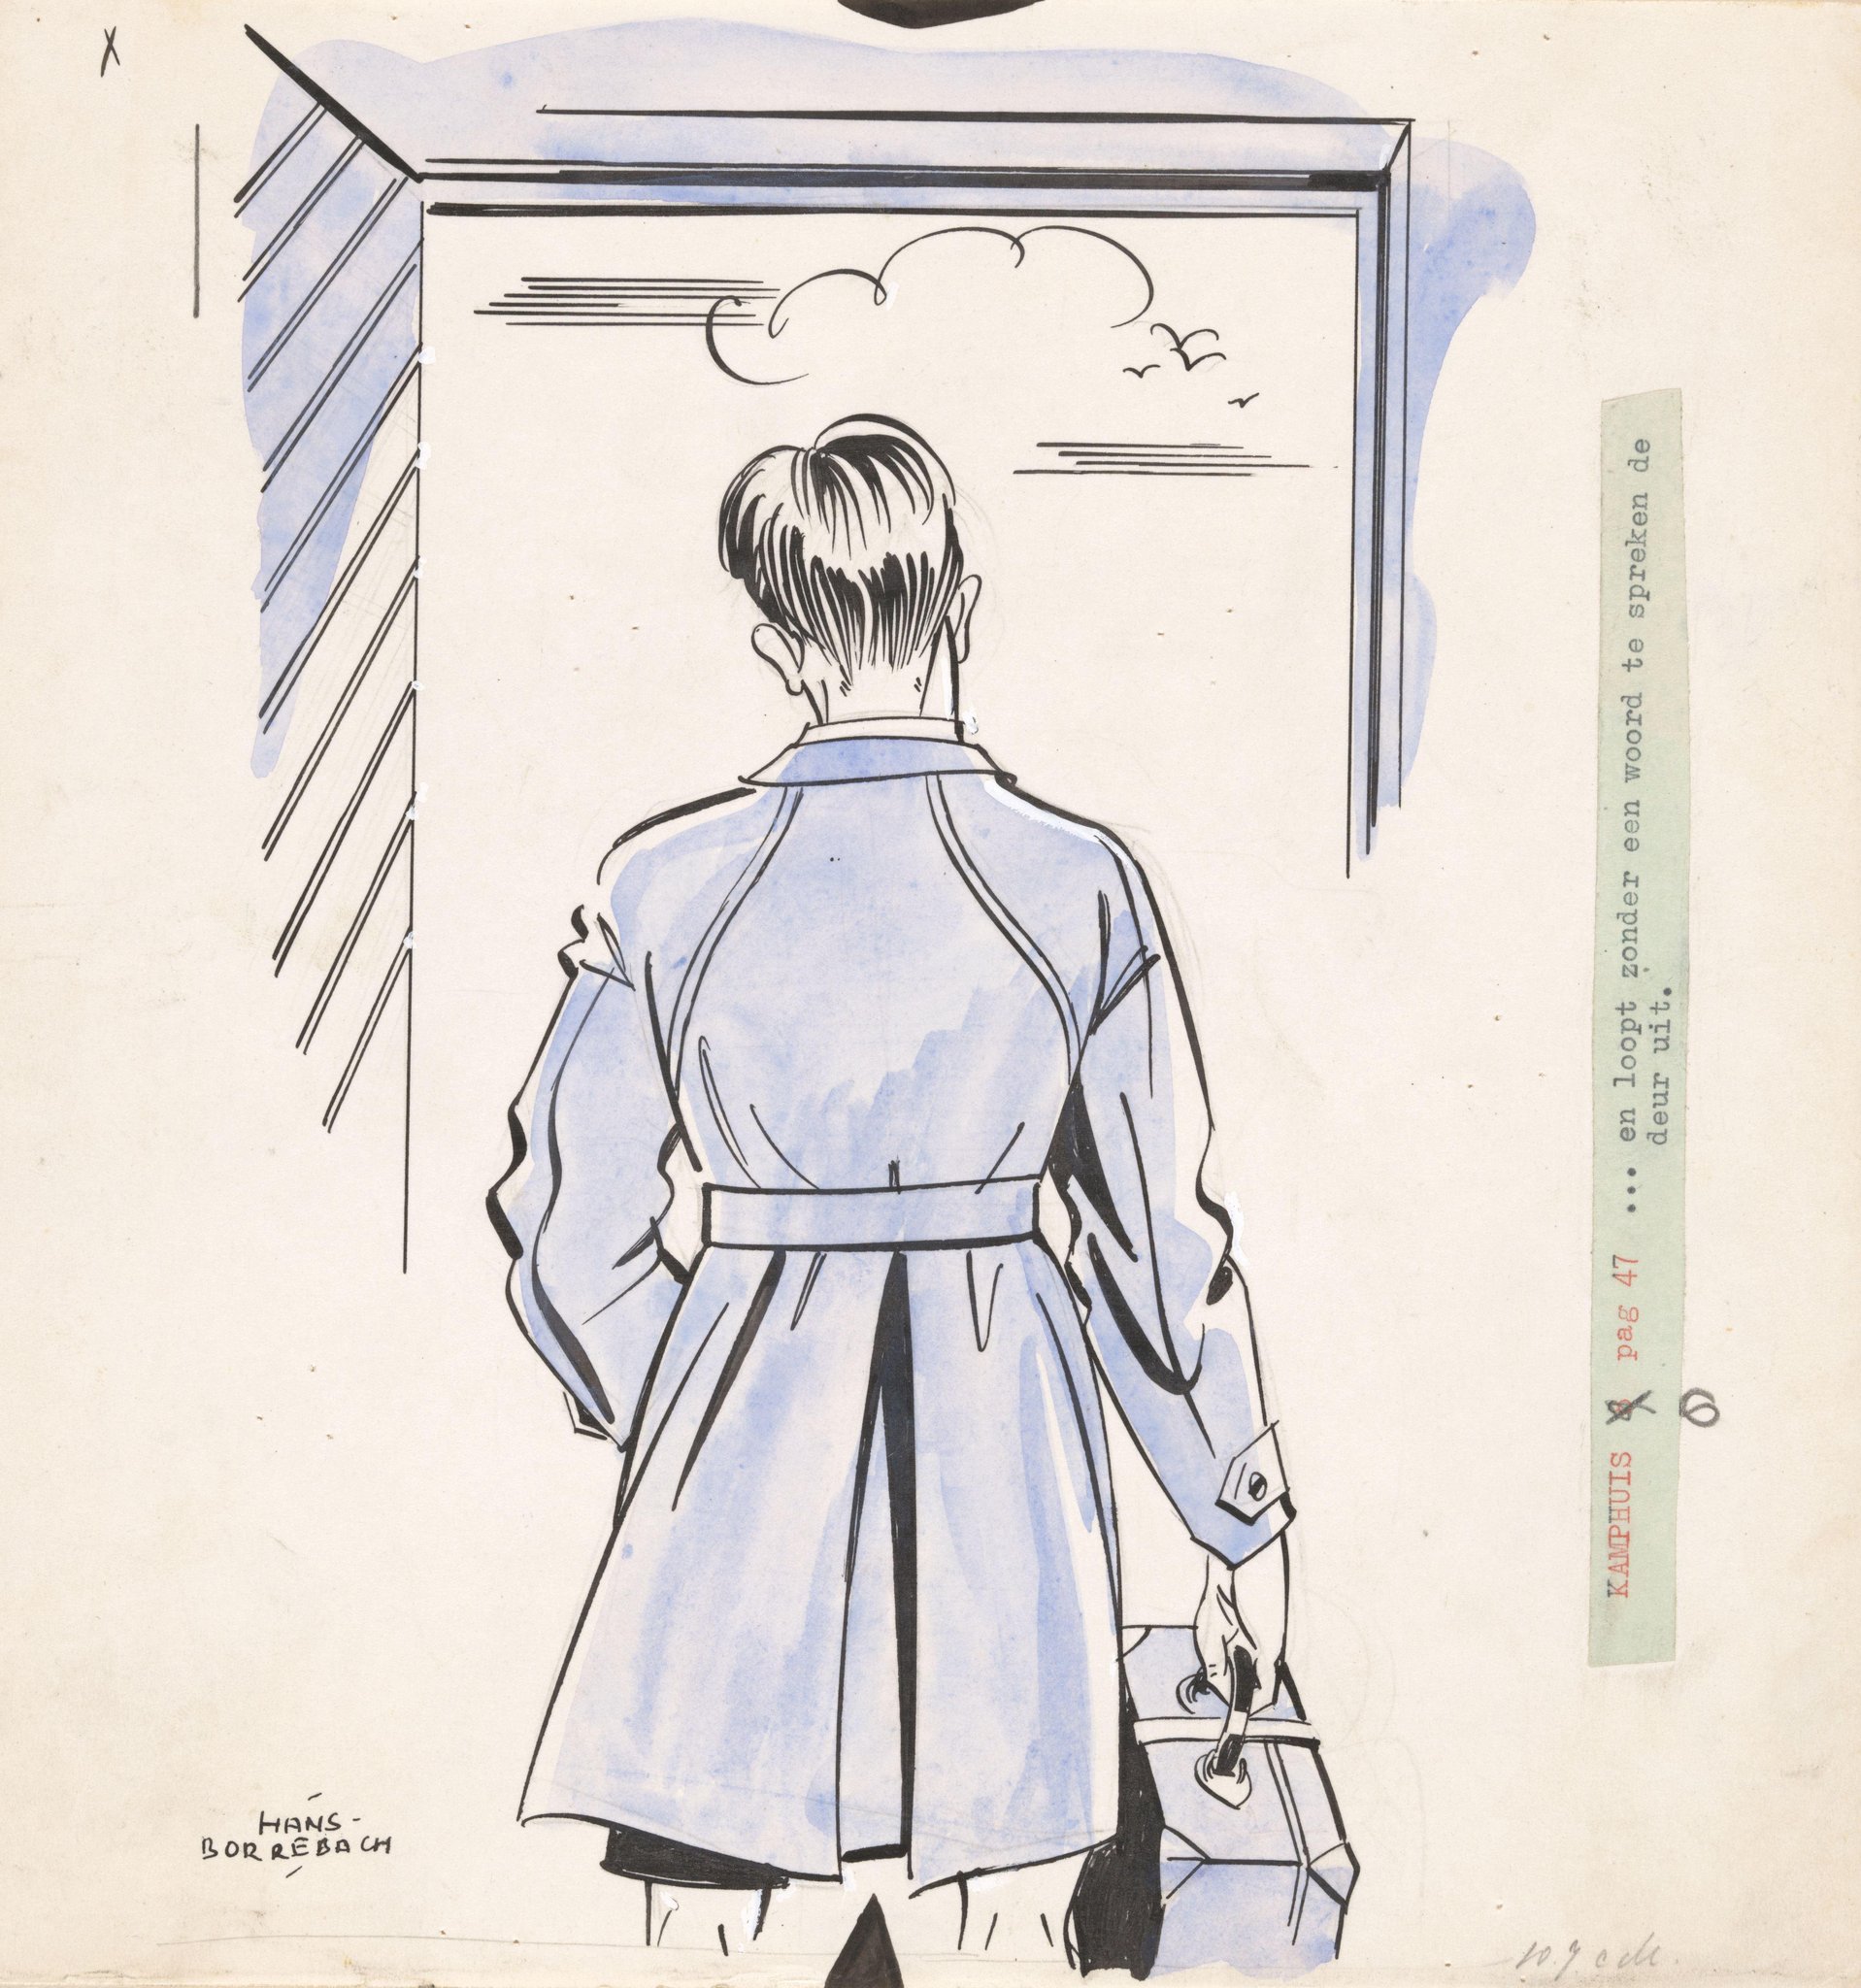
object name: drawing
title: Jonge man met koffer in een deuropening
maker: hans borrebach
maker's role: draughtsman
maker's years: 1903-1991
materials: paint, ink, paper, pencil, watercolor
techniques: brush, pen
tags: standing figure, open door, trunk, suit-case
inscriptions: collector's mark: Lugt 2228a, number: ‘X’, signature: ‘HANS./ BORREBACH’, annotation: ‘KAMPHUIS 8 pag 47 ... en loopt zonder een woord te spreken de/ deur uit.’, :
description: Ontwerp voor: Baljé, J.P. Het kamphuis in de duinen. Amsterdam: Veen, 1953.